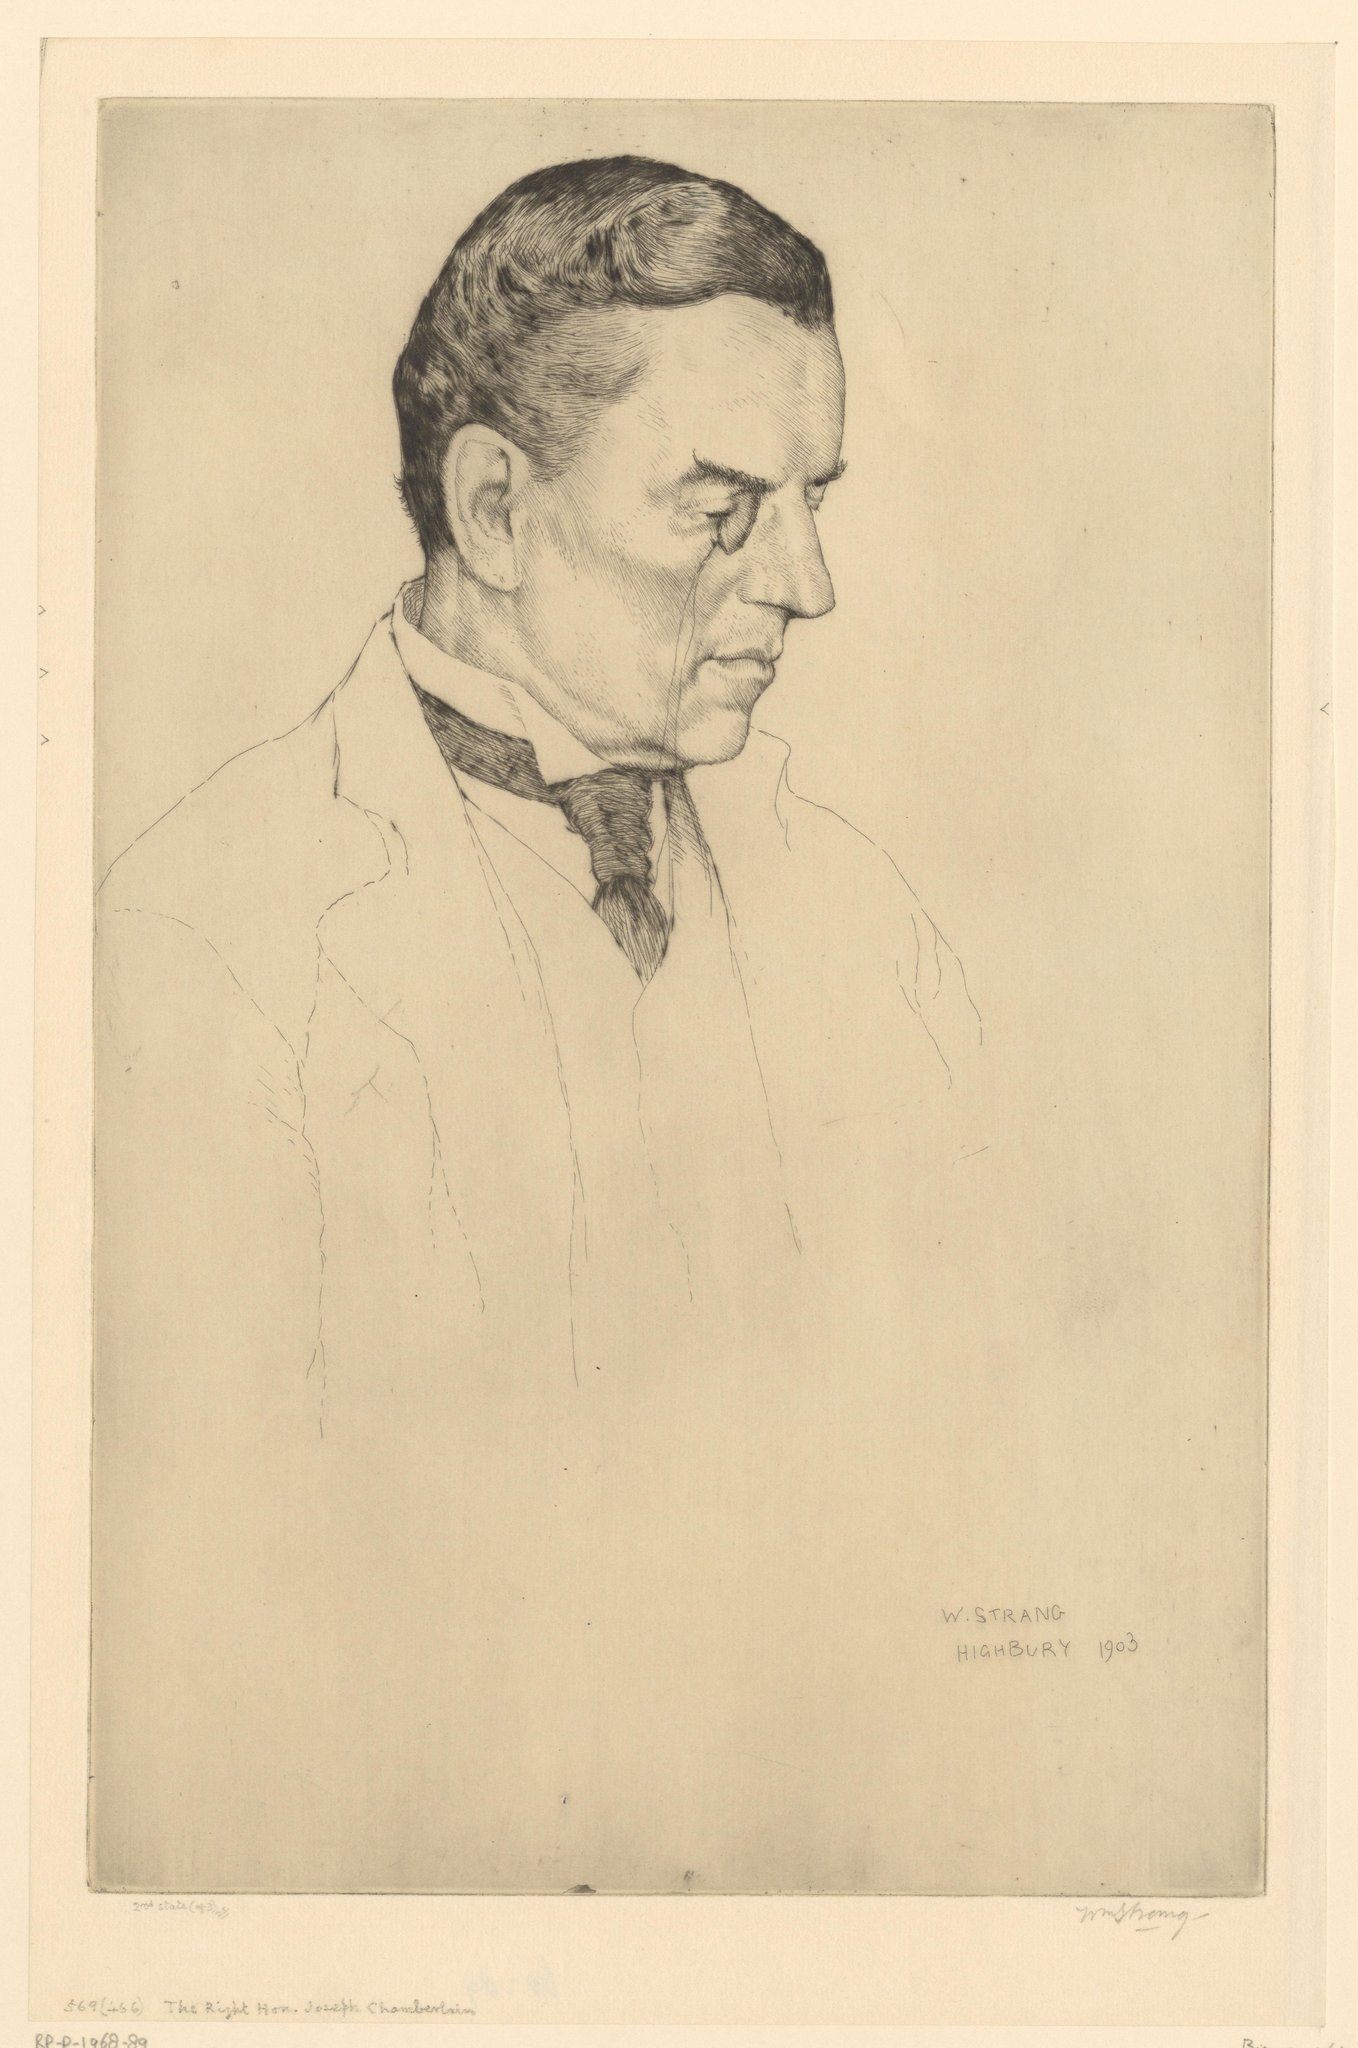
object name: print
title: Portret van Joseph Chamberlain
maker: william strang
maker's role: print maker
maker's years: 1859-1921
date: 1903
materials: paper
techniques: etching, intaglio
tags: politician, historical persons, politician, e.g. party leader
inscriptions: signature: ‘WmStrang’, collector's mark: Lugt 2760, inscription: ‘2nd state (of 3) D.S.’, collector's mark: Lugt 2228